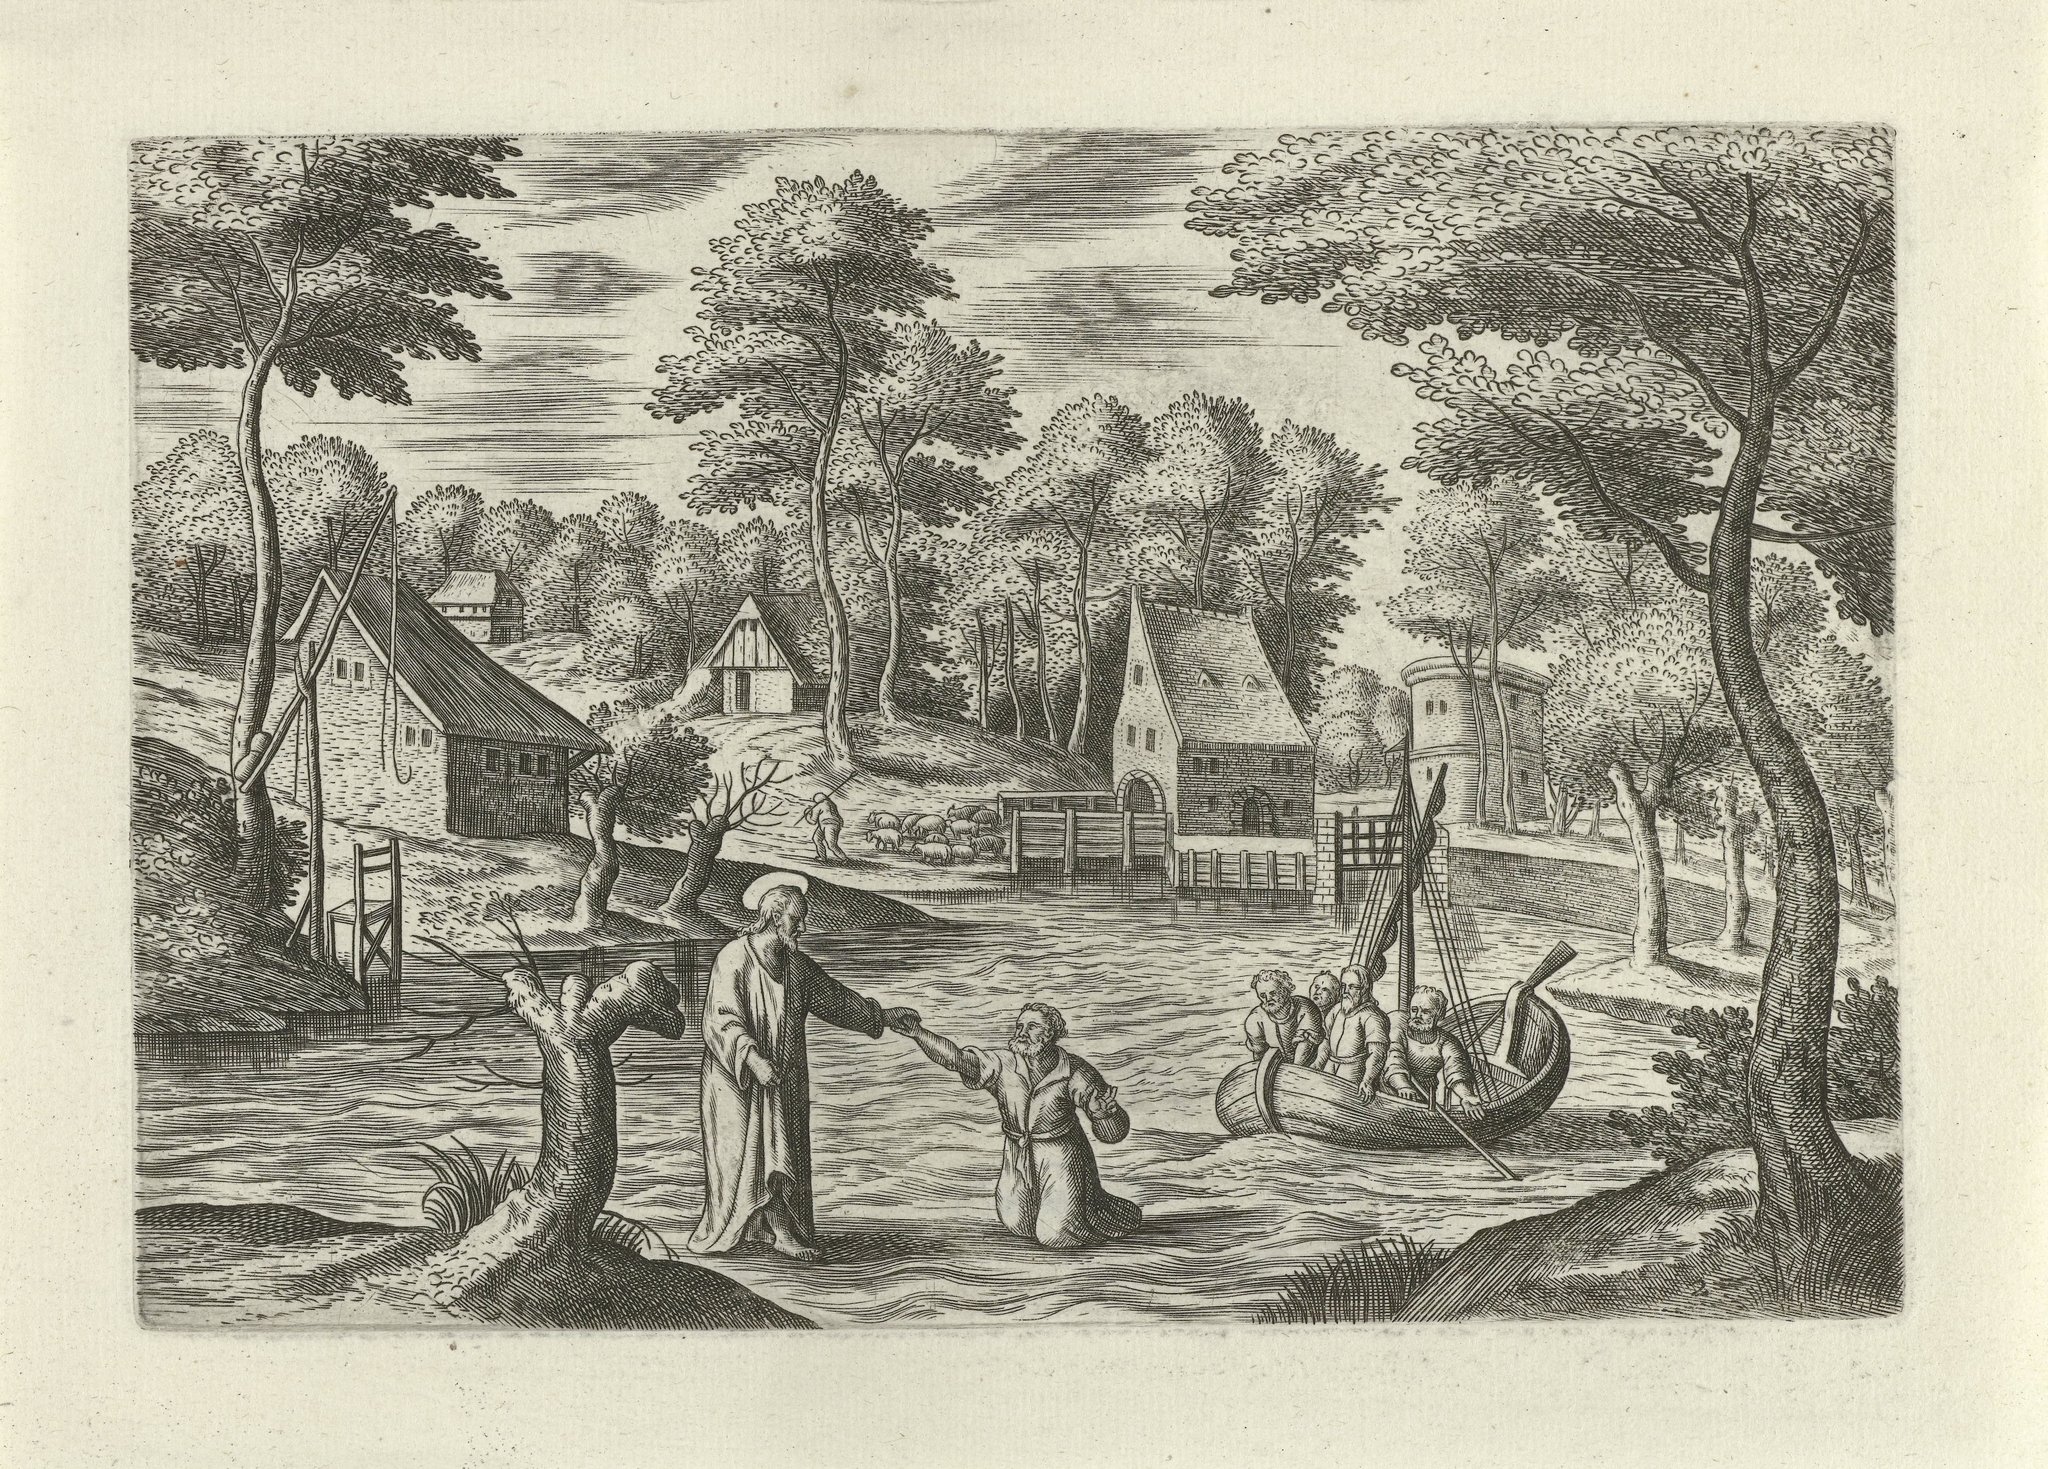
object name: print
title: Landschappen met scènes uit het Oude en Nieuwe Testament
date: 1560-1595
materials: paper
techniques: engraving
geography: antwerp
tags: peter steps out of the boat and tries to walk on the water towards christ, landscape with bridge, viaduct or aqueduct (+ city(-scape) with figures, staffage)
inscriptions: collector's mark: Lugt 2228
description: Christus loopt over het water van het meer van Galilea. Hij steekt zijn hand uit naar Petrus, die probeert naar zijn leermeester toe te wandelen, maar in het water zinkt. In een bootje vier van de andere discipelen. Op de achtergrond een brug en een herder met zijn schapen. De prent is deel van een vierdelige serie van landschappen met scènes uit het Oude en Nieuwe Testament.